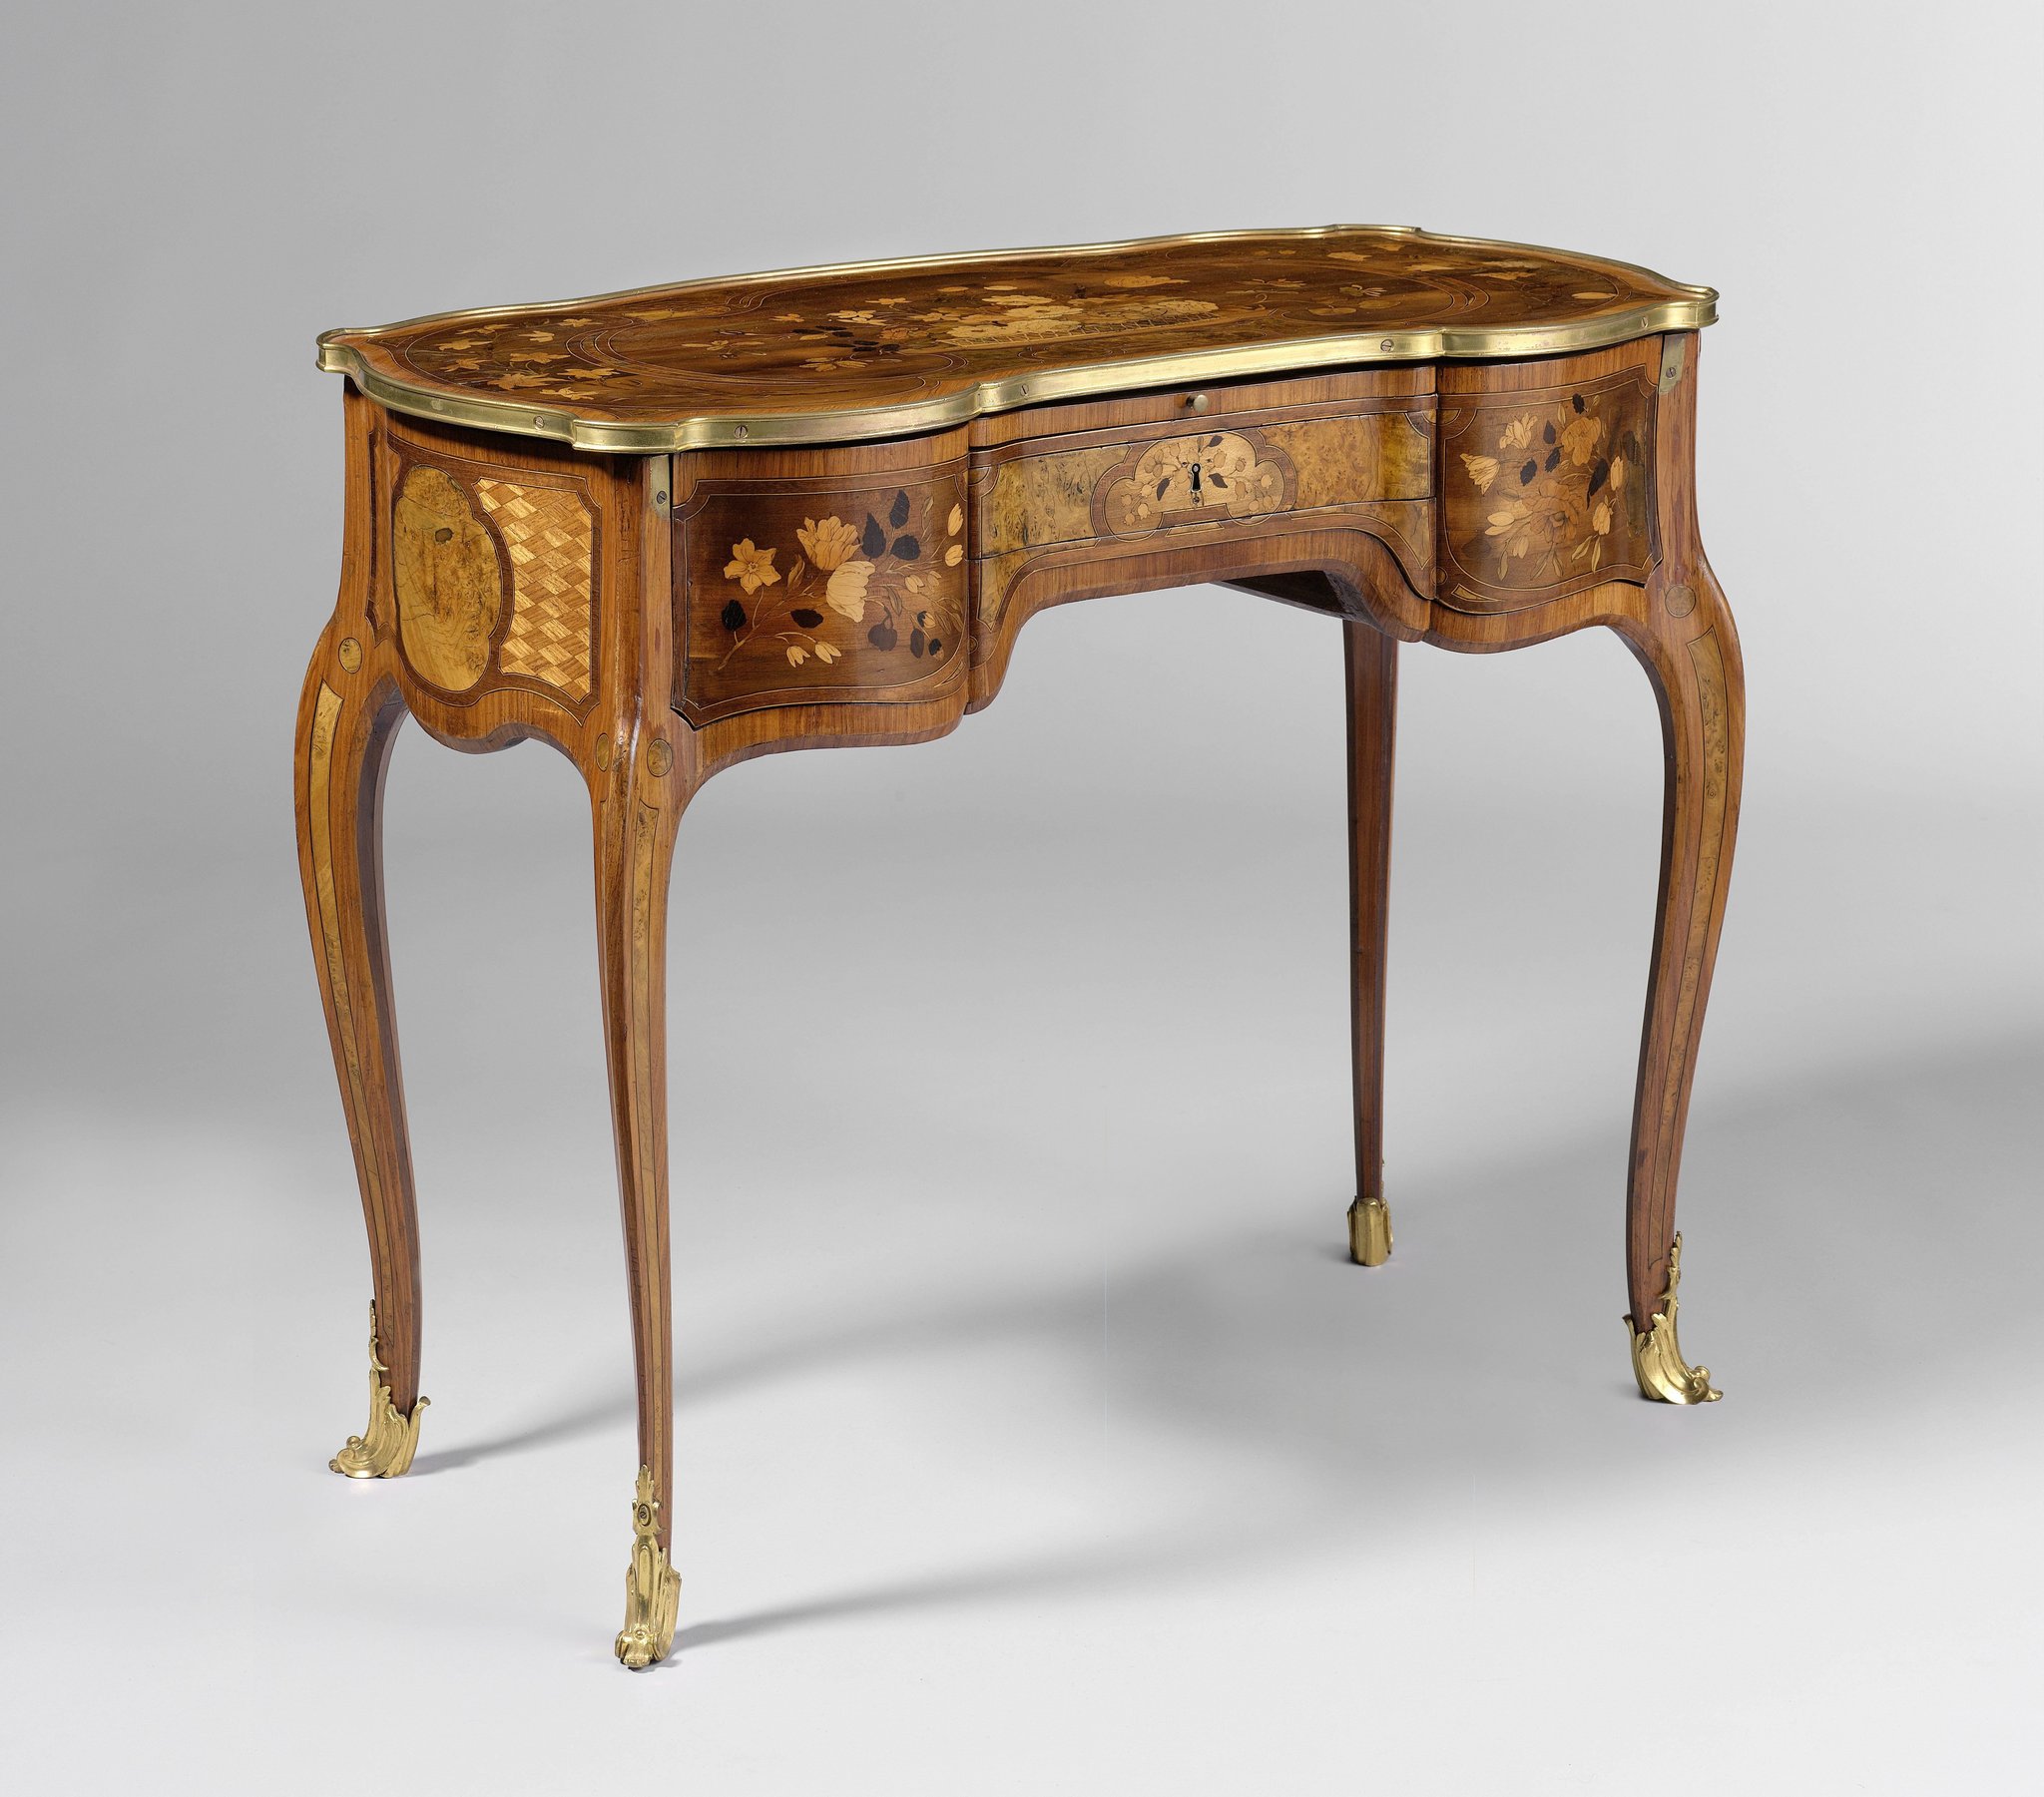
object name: table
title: Writing and dressing table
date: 1762-1768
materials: bronze, wood, leather, glass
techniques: gilding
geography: paris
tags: ornaments ~ art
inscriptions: signature: ‘J.H.RIESENER’, mark, signature: ‘J.F.OEBEN’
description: After Oeben died, his widow continued his workshop: guild regulations allowed her to keep using her dead husband’s name stamp. The workshop was headed by Riesener, who married Oeben’s widow in 1767 and became a master cabinetmaker a year later; he then began to use his own stamp. The underside of this table bears both stamps, indicating that Riesener at least completed it.